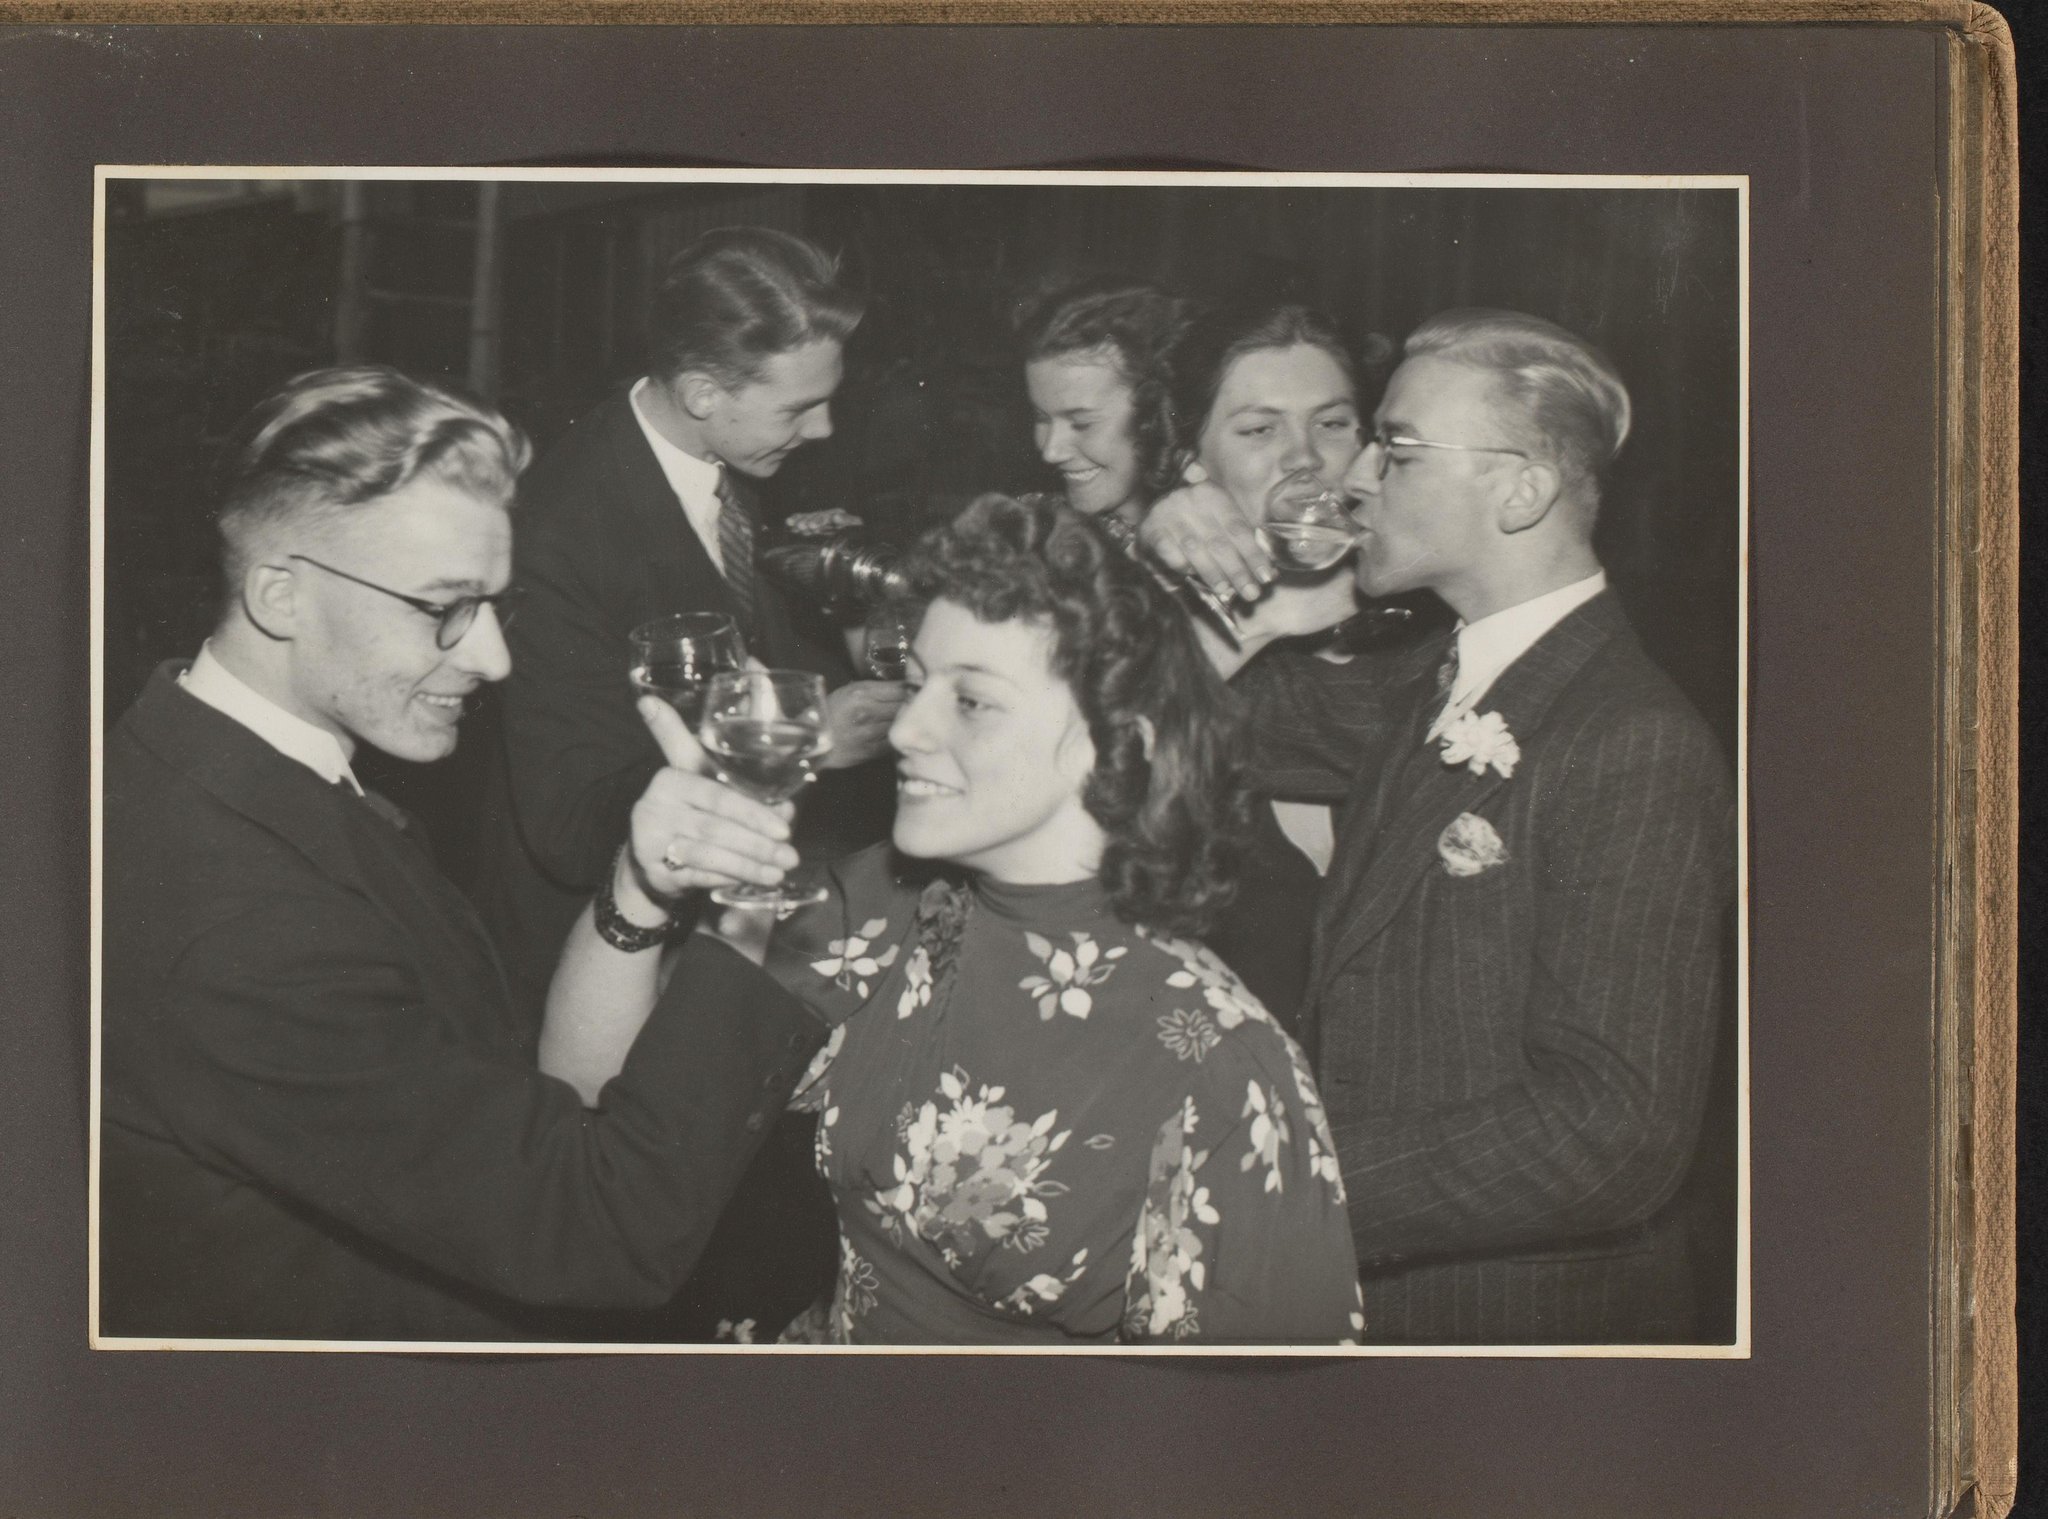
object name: photograph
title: Leerlingen van de MTS te Haarlem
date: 1935-1936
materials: paper, photographic support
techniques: gelatin silver print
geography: haarlem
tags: students' organization, vocational education, e.g.: junior technical school, haarlem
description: Albumblad met een foto van zes leerlingen van de MTS te Haarlem die een borrel drinken. Onderdeel van het fotoalbum 'Jaarfeesten van het Corps M.T.S. te Haarlem'.